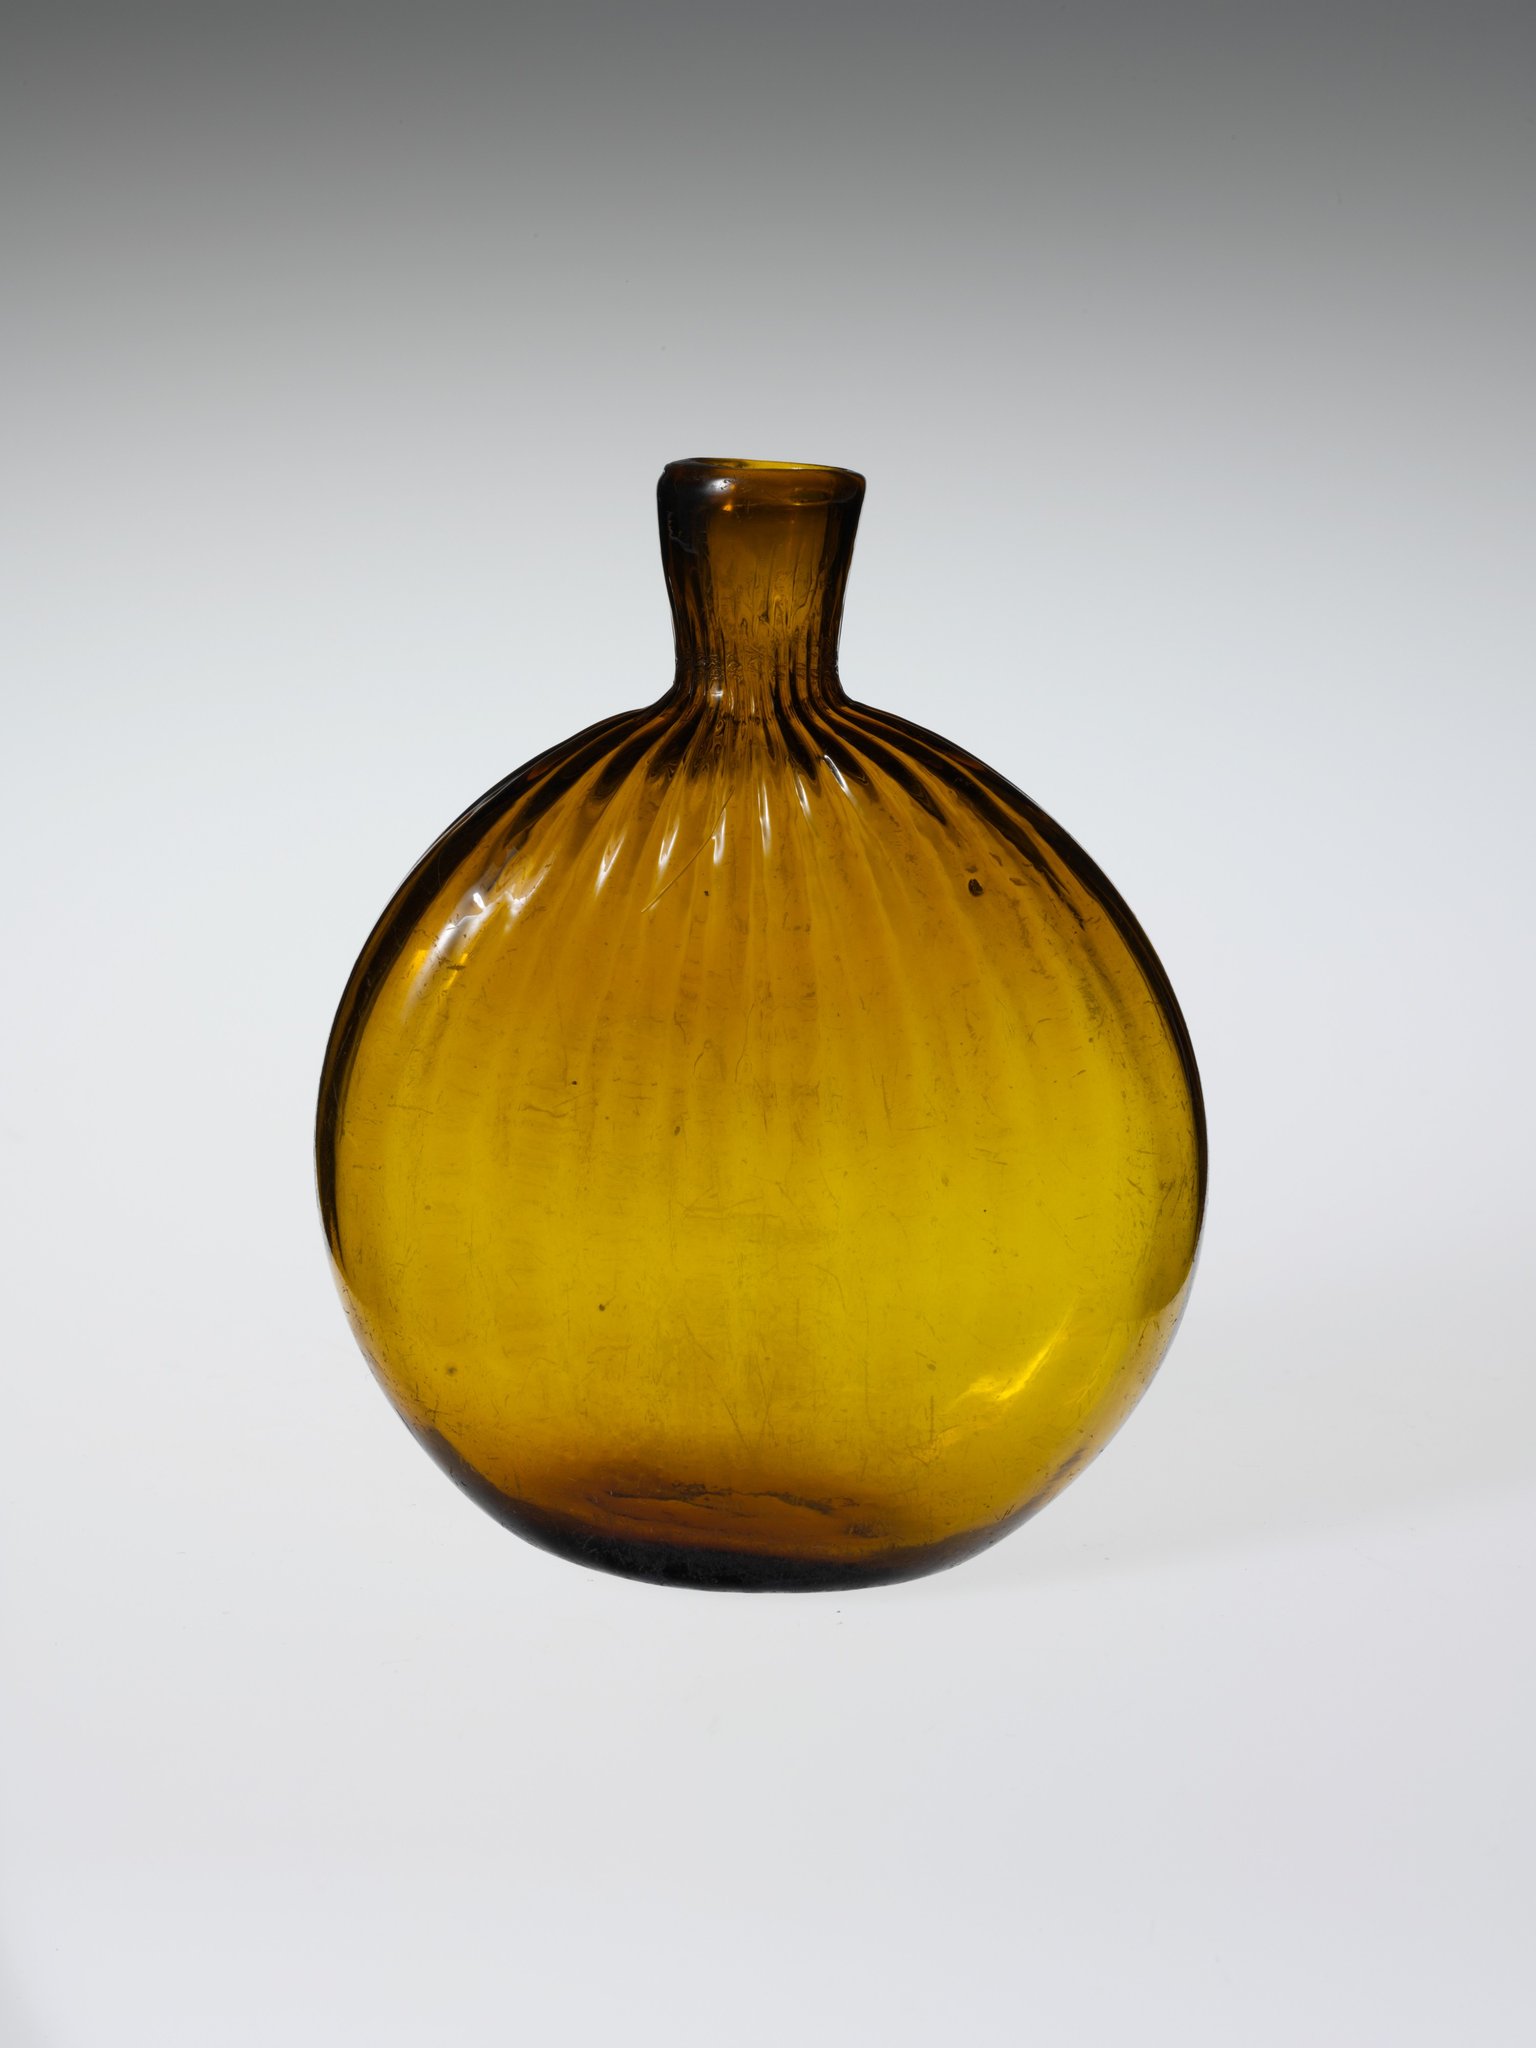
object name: pocket bottle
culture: american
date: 1820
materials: glass, lead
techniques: glassblowing, molding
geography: united states